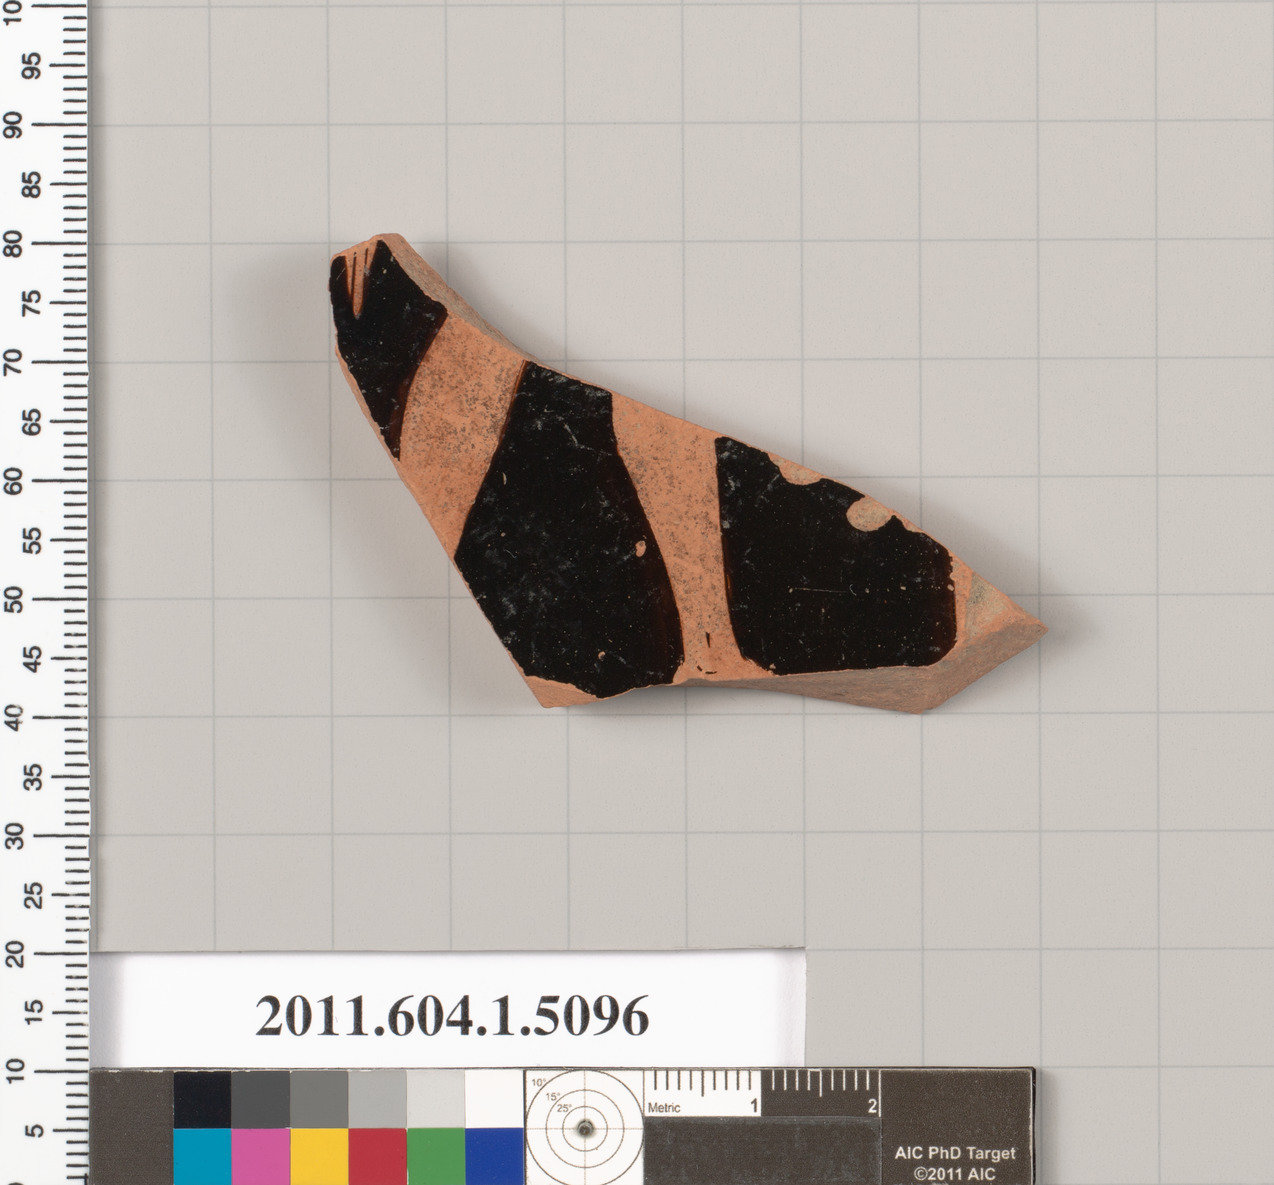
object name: kylix fragment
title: Terracotta fragment of a kylix (drinking cup)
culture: greek, attic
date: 490-470 BCE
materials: terracotta